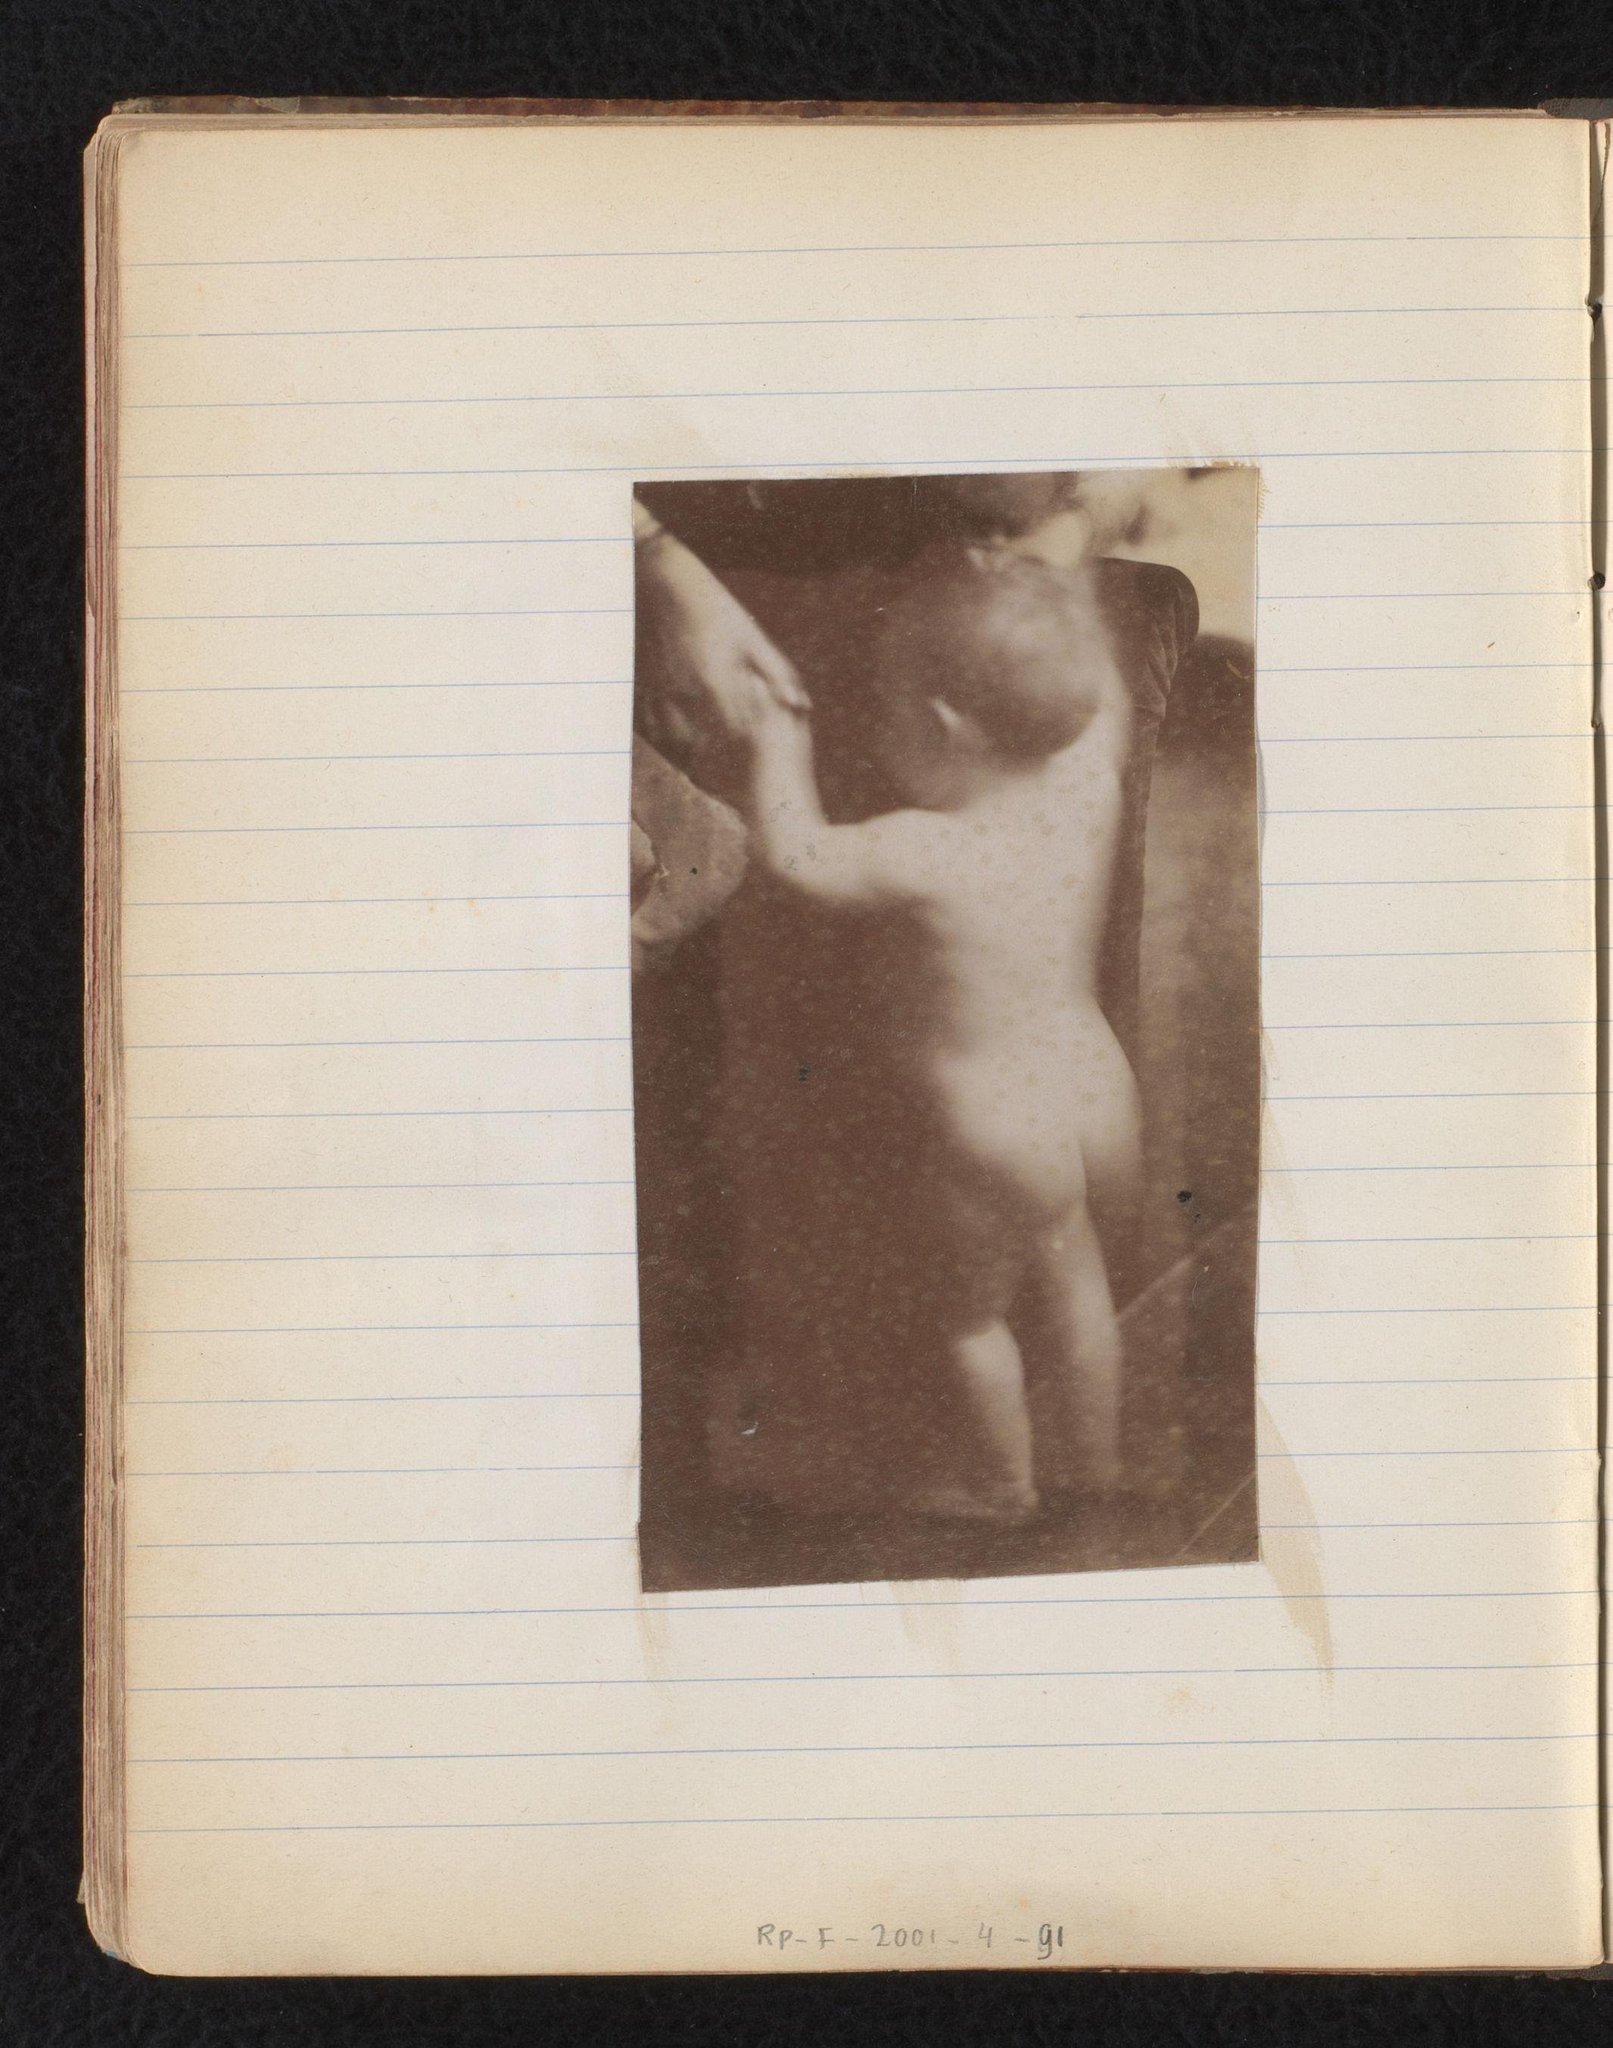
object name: album leaf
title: Studie van een naakte peuter en vrouw, door Jacques de Lalaing, voorstudie voor Heilige Maagd met het kind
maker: jacques lalaing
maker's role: painter, sculptor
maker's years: 1858-1917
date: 1900-1914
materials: photographic support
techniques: albumen print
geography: brussels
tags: infant, baby, artist (in general) working from nude model, the (nude) human figure; 'corpo humano' (ripa) (+ back view)